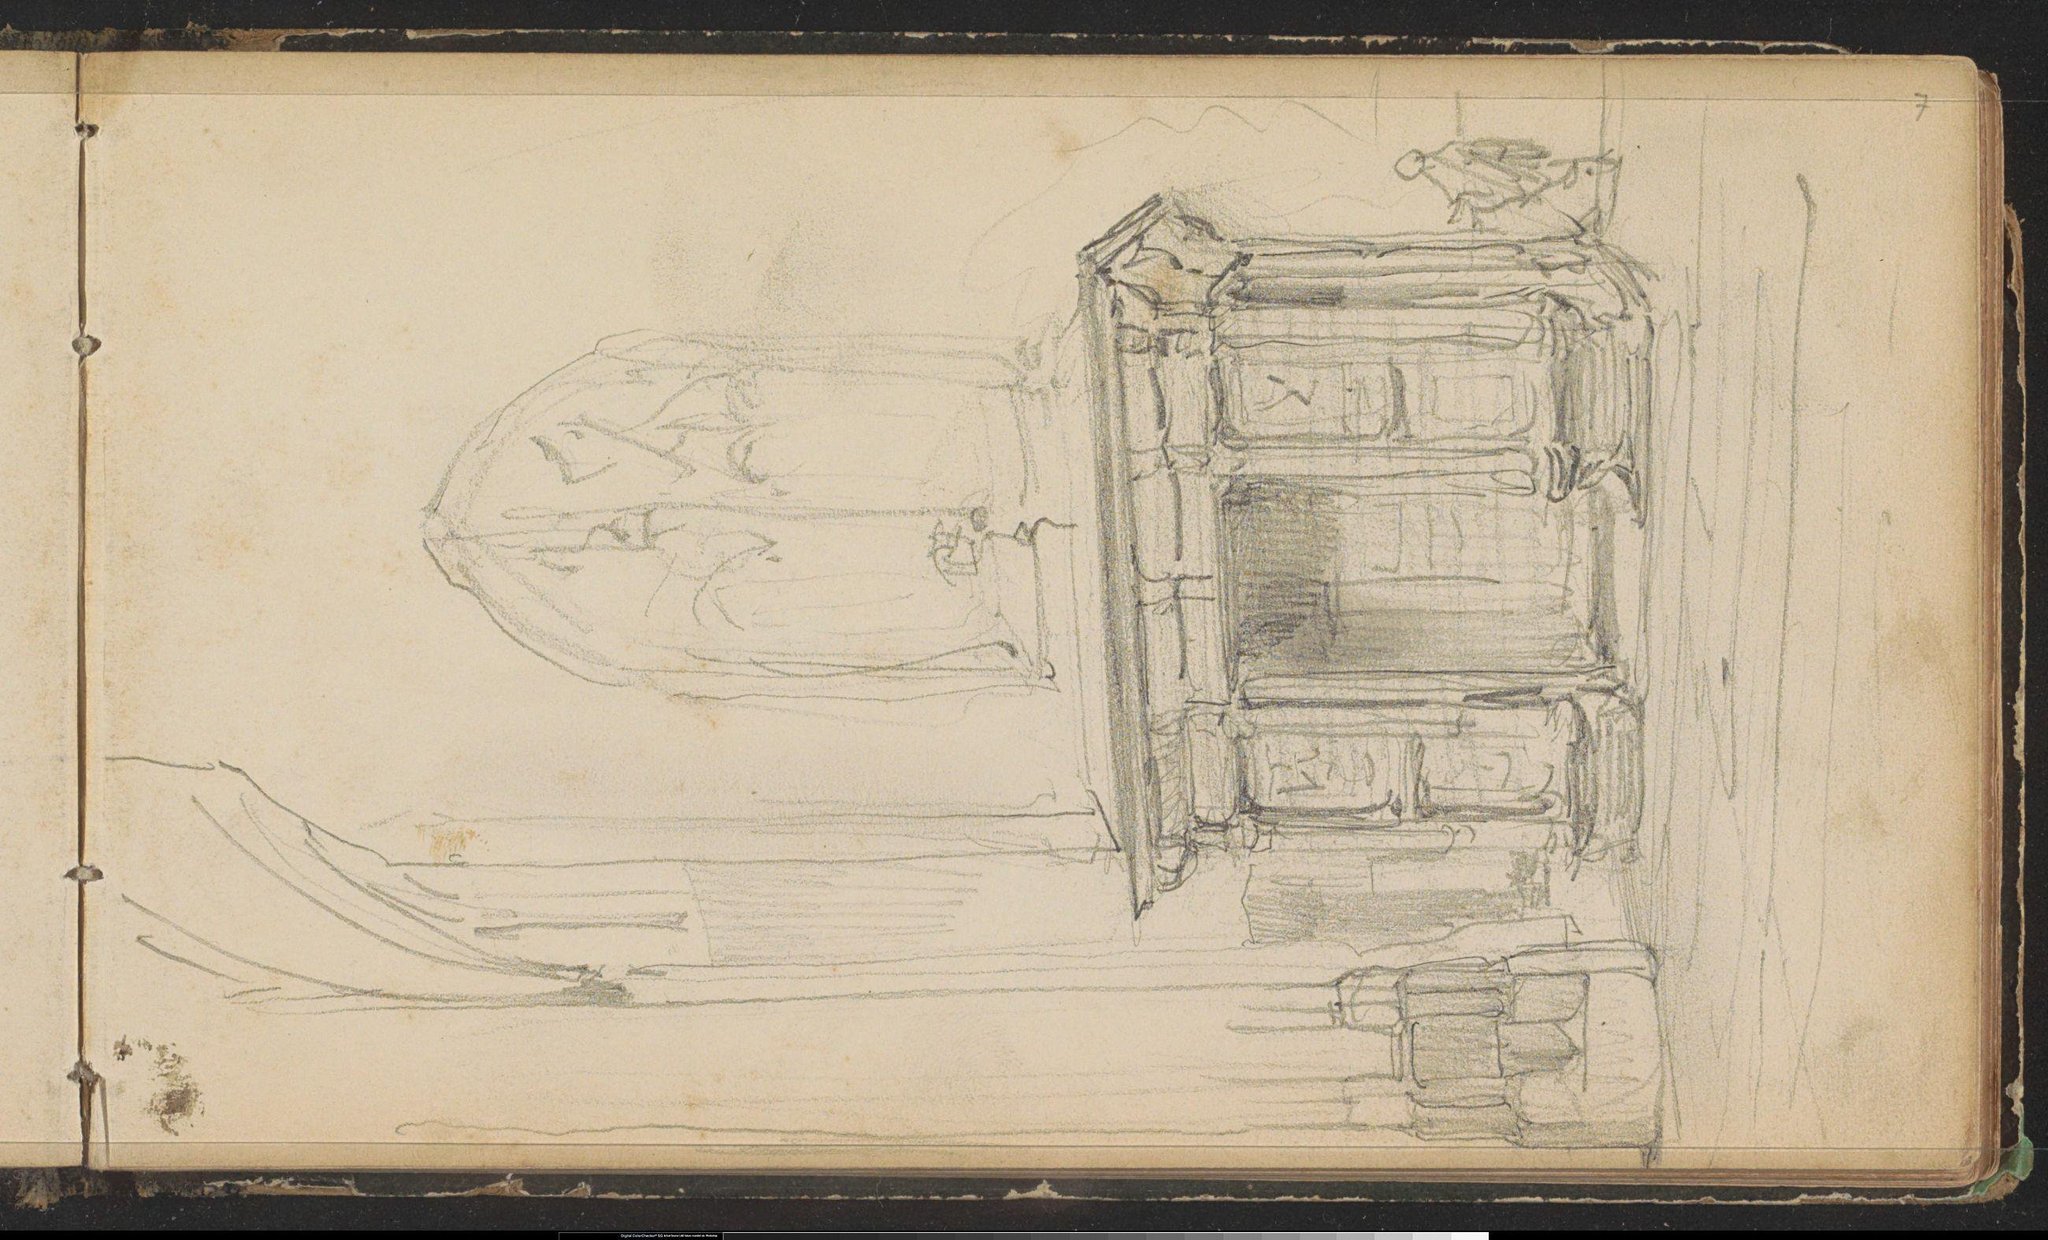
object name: sketchbook leaf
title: Deel van een kerkinterieur, mogelijk met een biechthok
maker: johannes bosboom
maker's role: draughtsman, painter, print maker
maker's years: 1817-1891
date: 1845-1891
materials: paper, pencil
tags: parts of church interior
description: Blad 7 recto uit een schetsboek met 46 bladen.